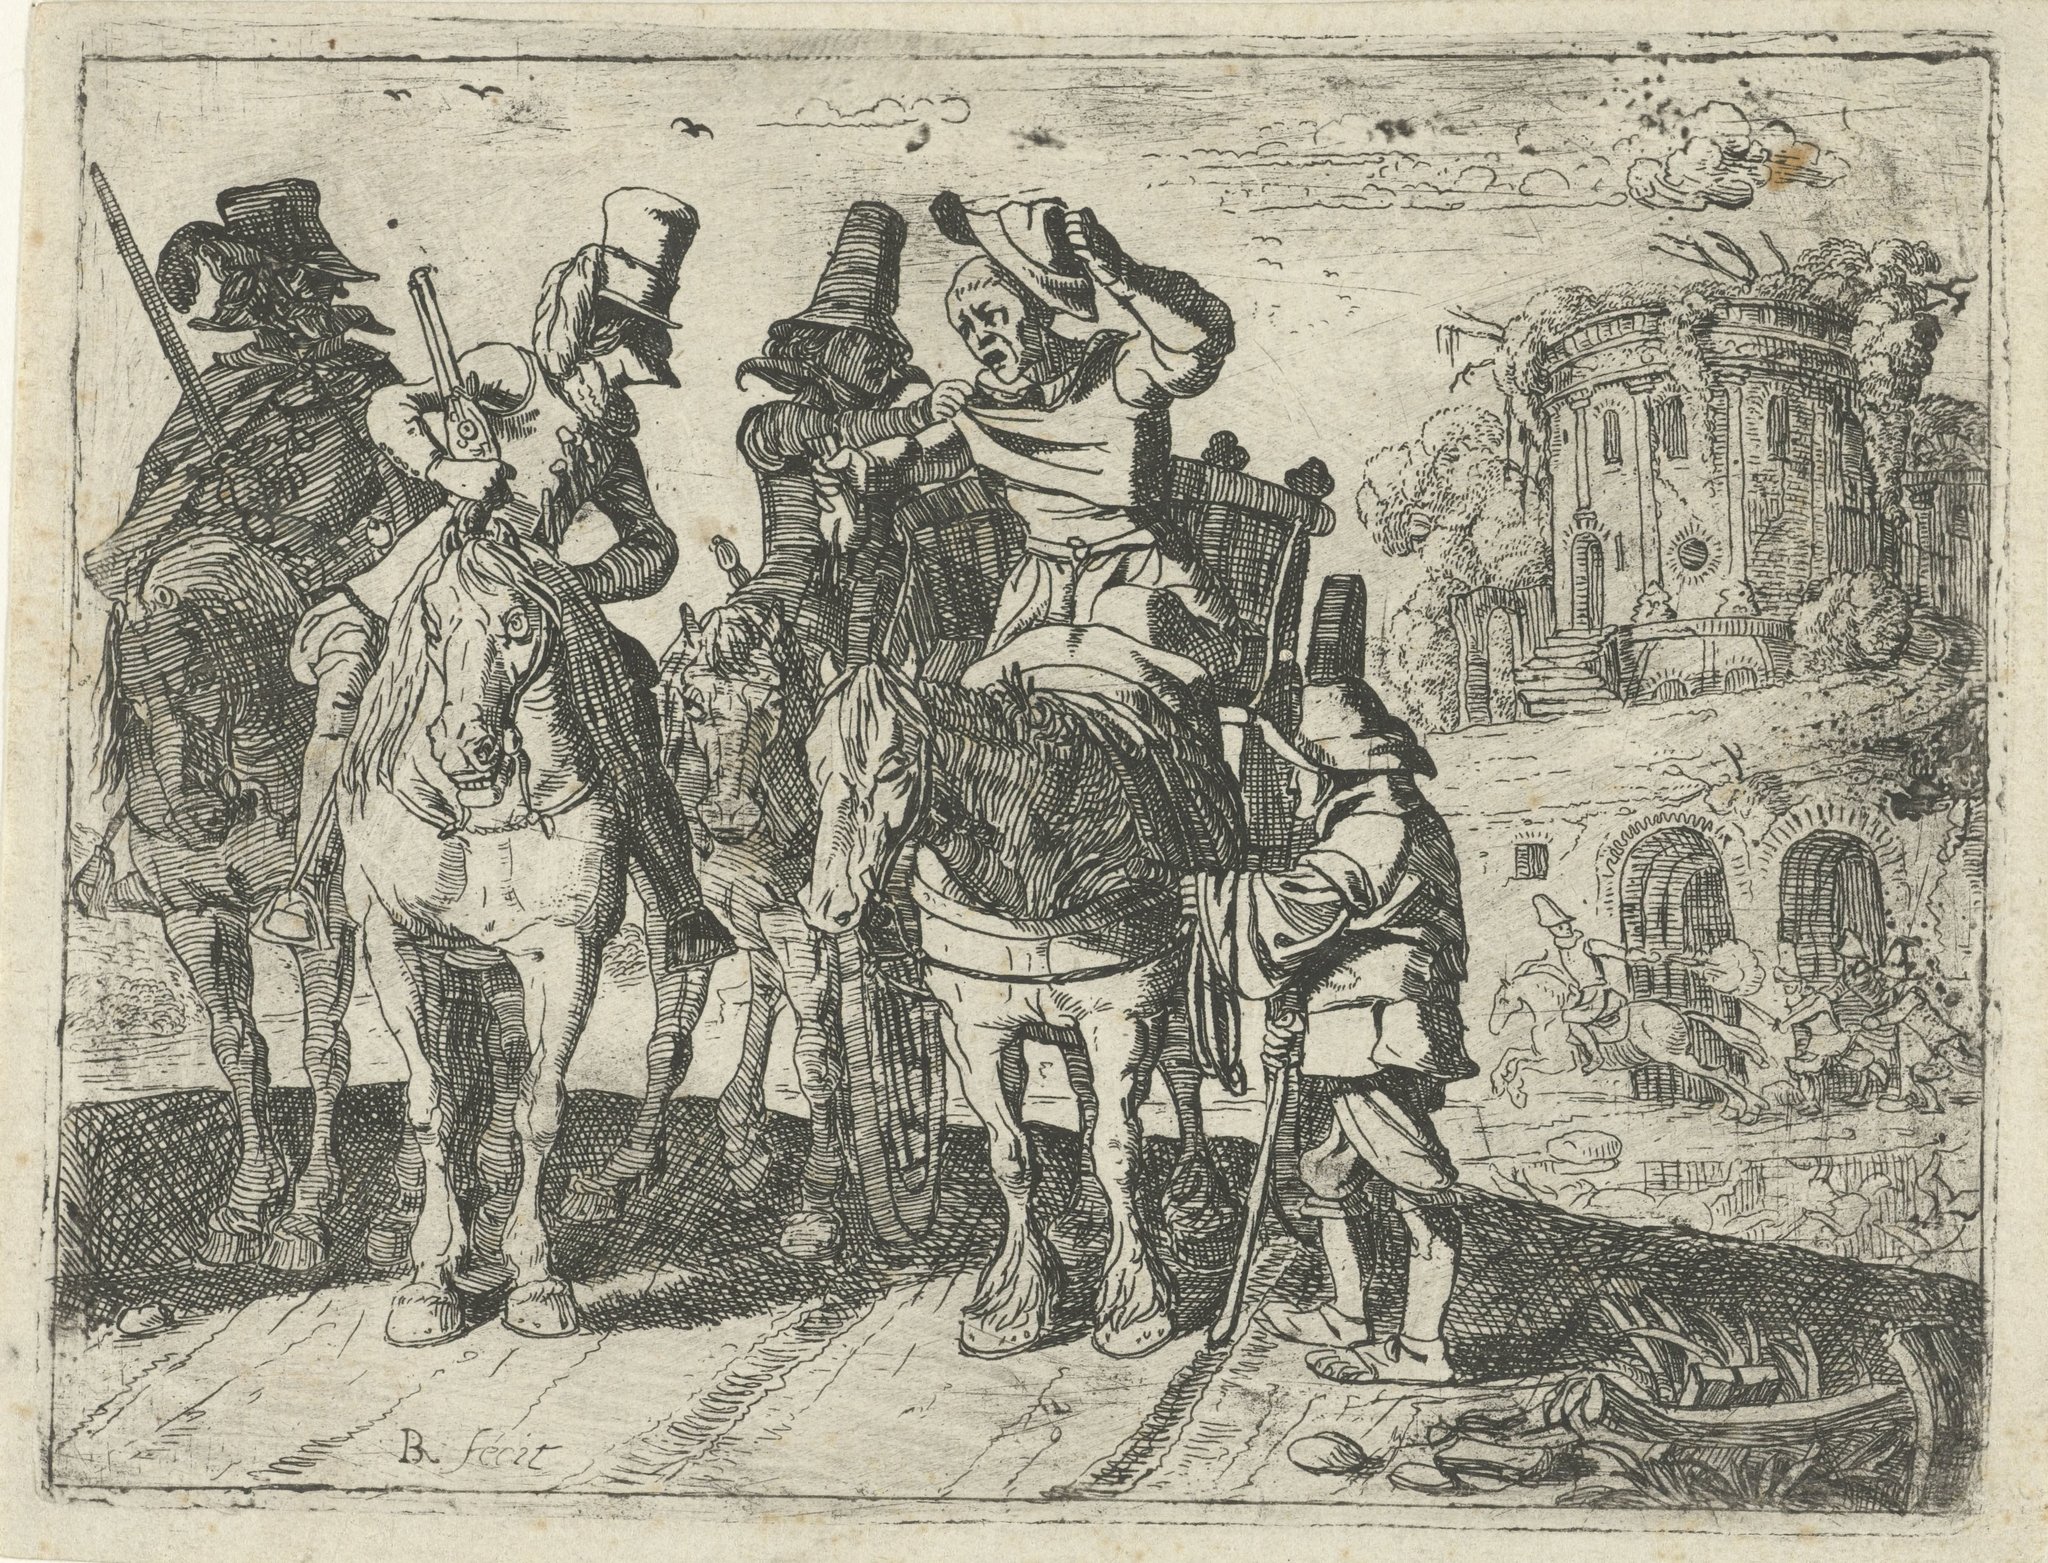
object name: print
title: Boer overvallen door struikrovers te paard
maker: roeland van laer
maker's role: print maker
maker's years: 1598-1640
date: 1605-1673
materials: paper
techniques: etching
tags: riding a horse, ass, or mule; rider, horseman, robber, surprise attack (from ambush)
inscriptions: collector's mark: Lugt 240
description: Eerder door J.G. van Gelder toegeschreven (mondeling via C. Ackley, Boston) aan Roeland van Laer. Zie Hollstein prent in Wenen.